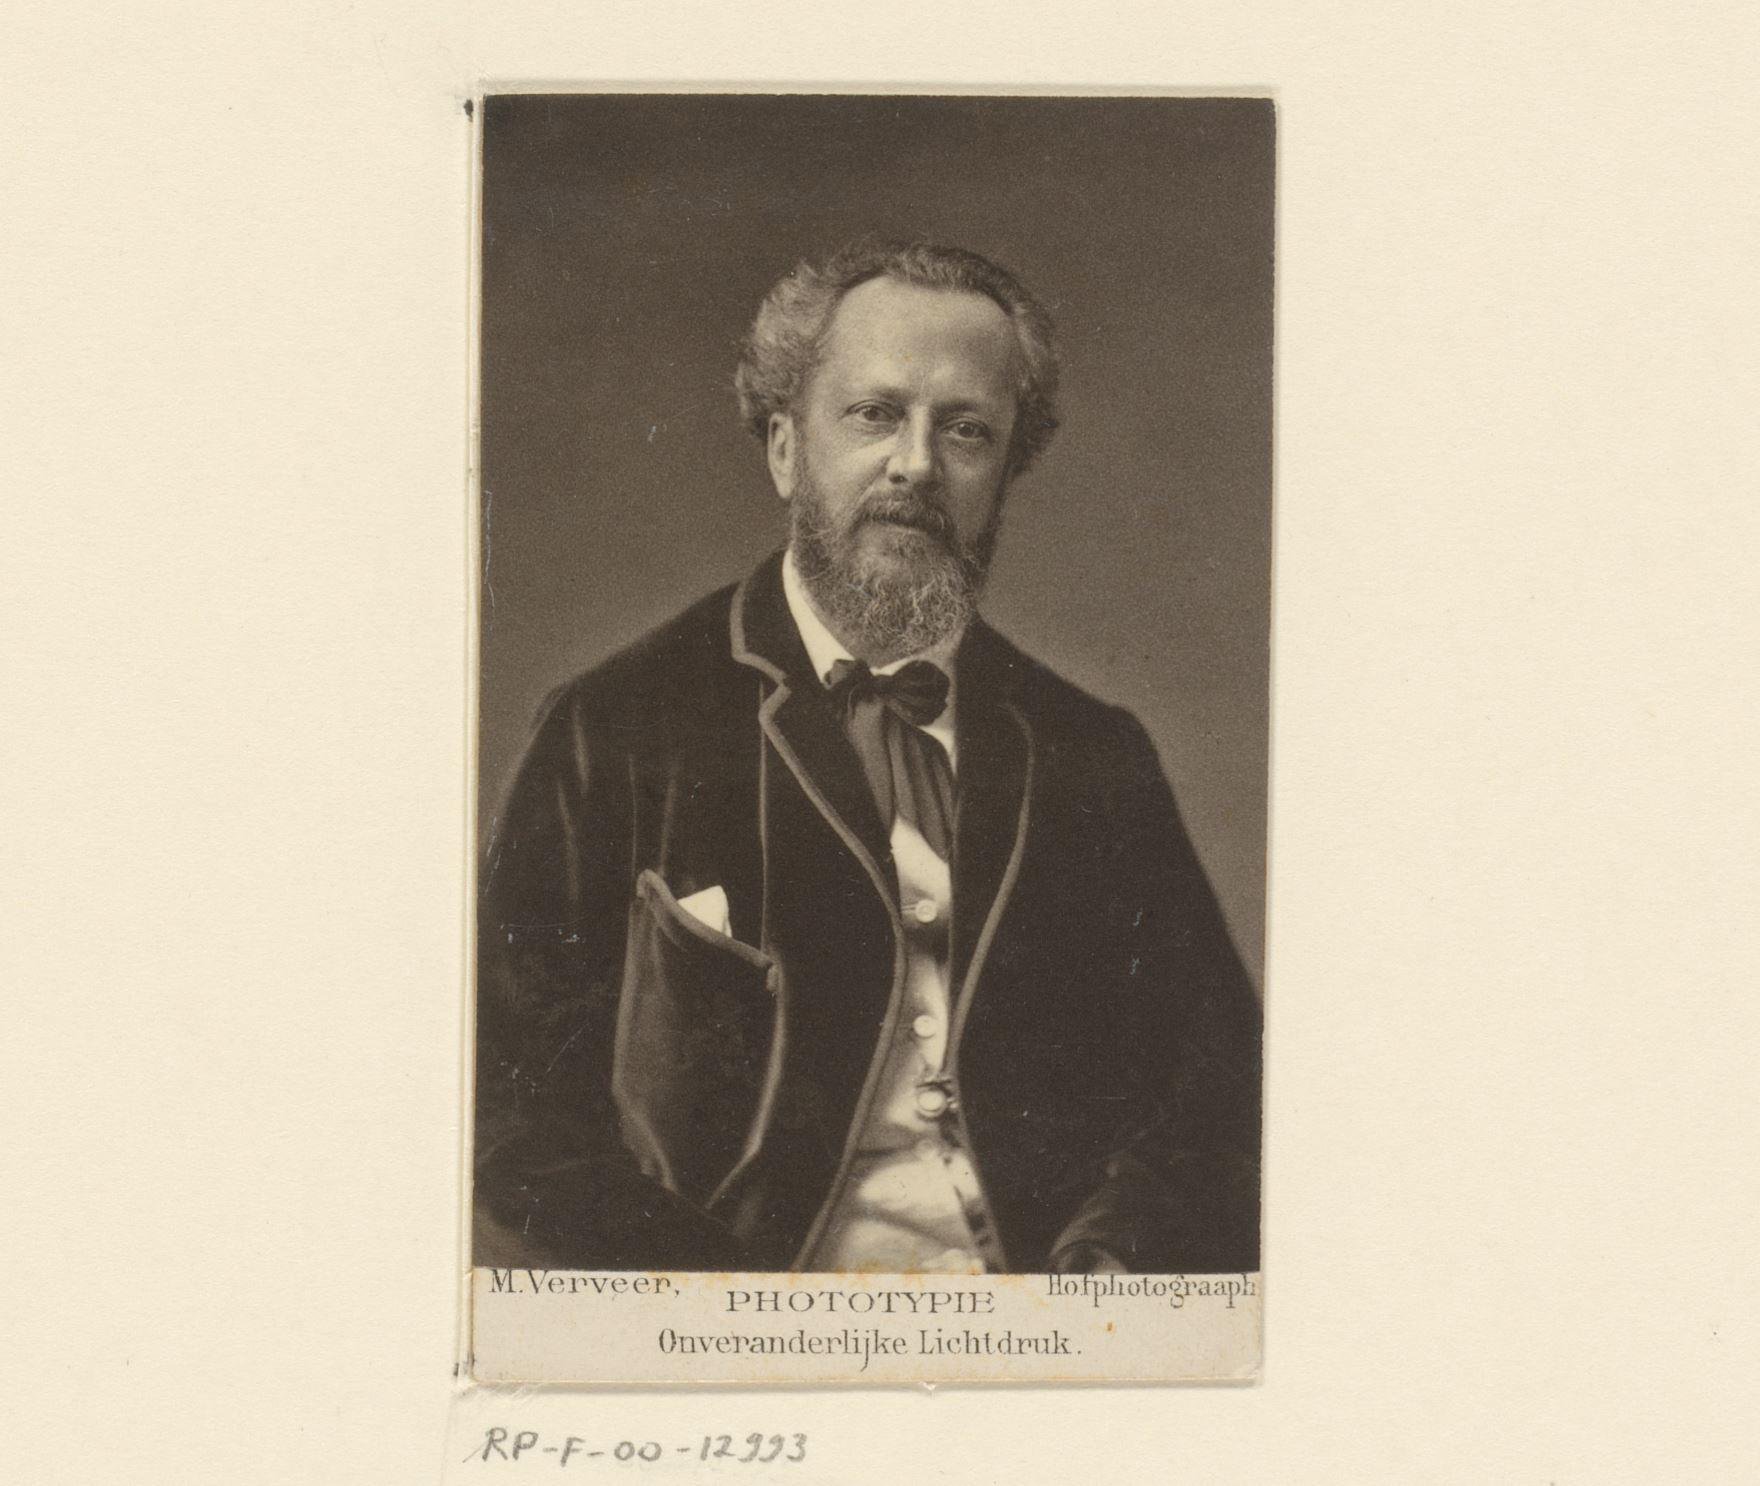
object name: photomechanical print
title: Stroebel schilder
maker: maurits verveer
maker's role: painter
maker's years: 1817-1903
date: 1872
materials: cardboard, paper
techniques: photograph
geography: the hague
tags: the hague, leiden, painter, print maker, draughtsman, johannes stroebel, historical persons, portrait, self-portrait of painter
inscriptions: inscription: ‘M. Verveer Photographe/ de LL. M.M. le Roi et la Reine/ des Pays-Bas/ 52, Zeestraat, vis-à-vis du Willemspark, 52/ La Haye.’, inscription: ‘J.A.B. Stroebel geb. 23/11/ 1821/ Souvenir à [...]/ Heer Roch/ Stroebel/ 's Hage 11 D. 72’